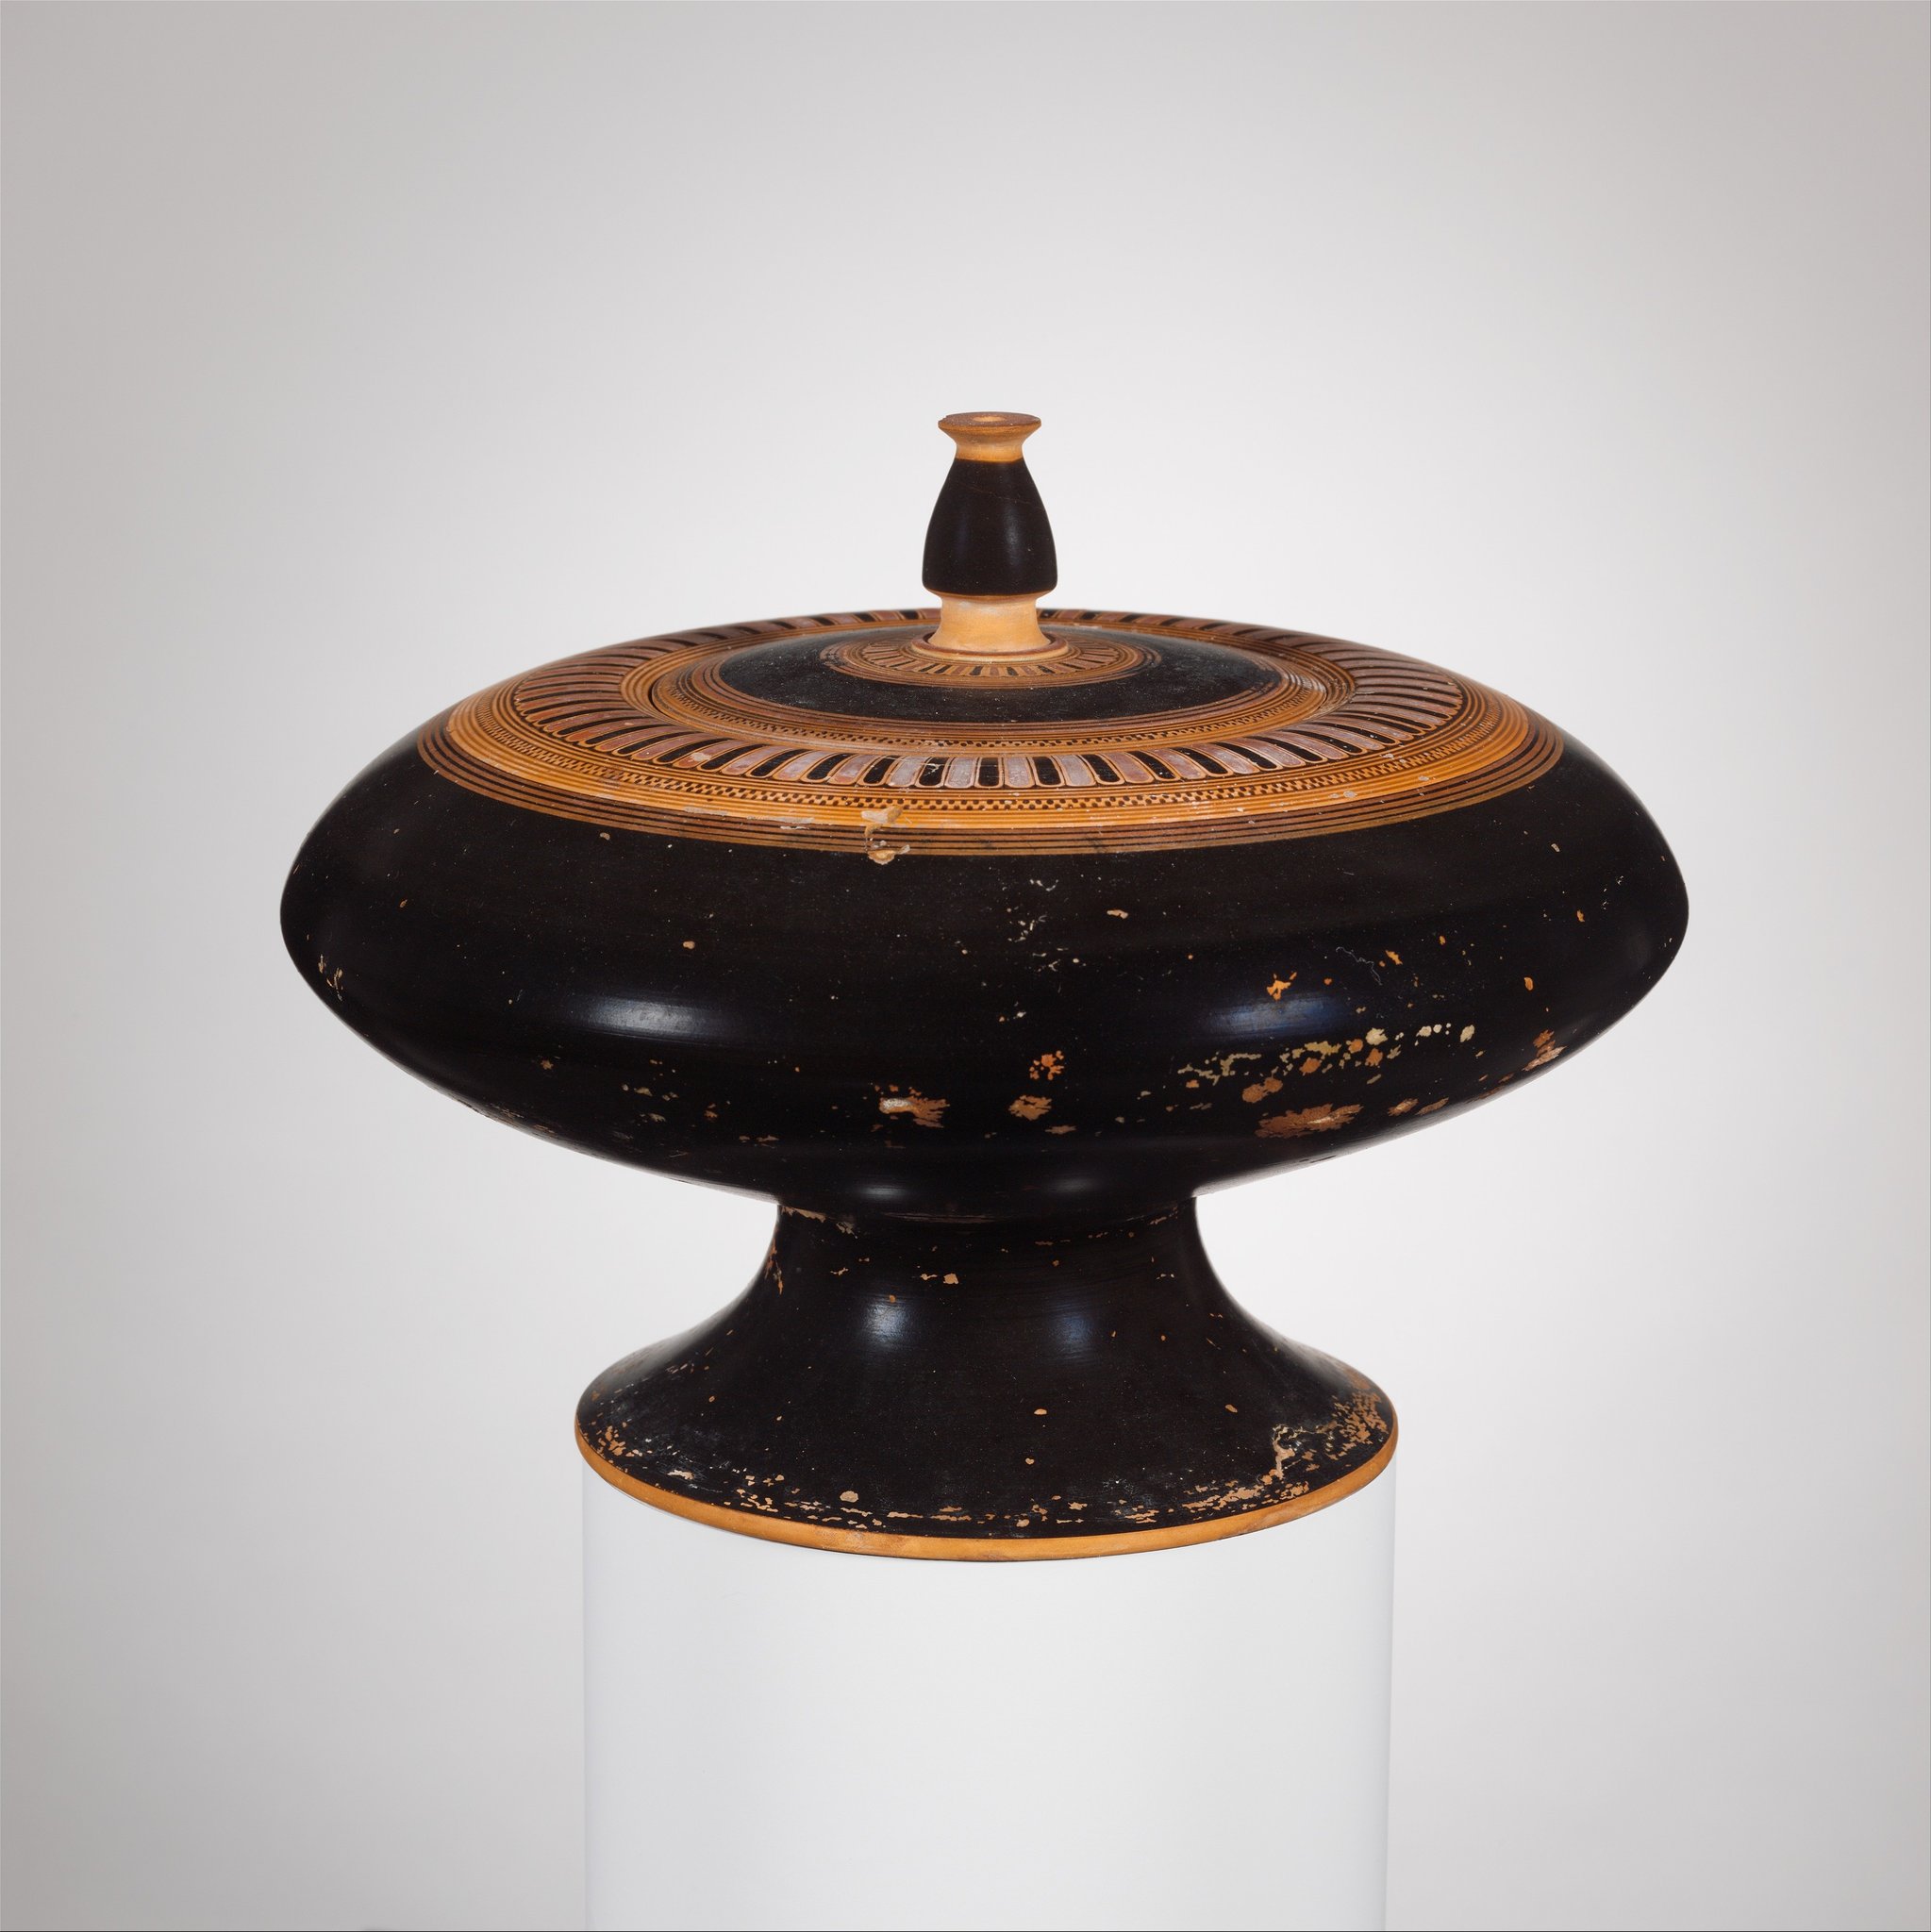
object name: plemochoe with lid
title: Terracotta plemochoe (vase for perfume)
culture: greek, attic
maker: kothons type a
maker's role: artist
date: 534-501 BCE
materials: terracotta